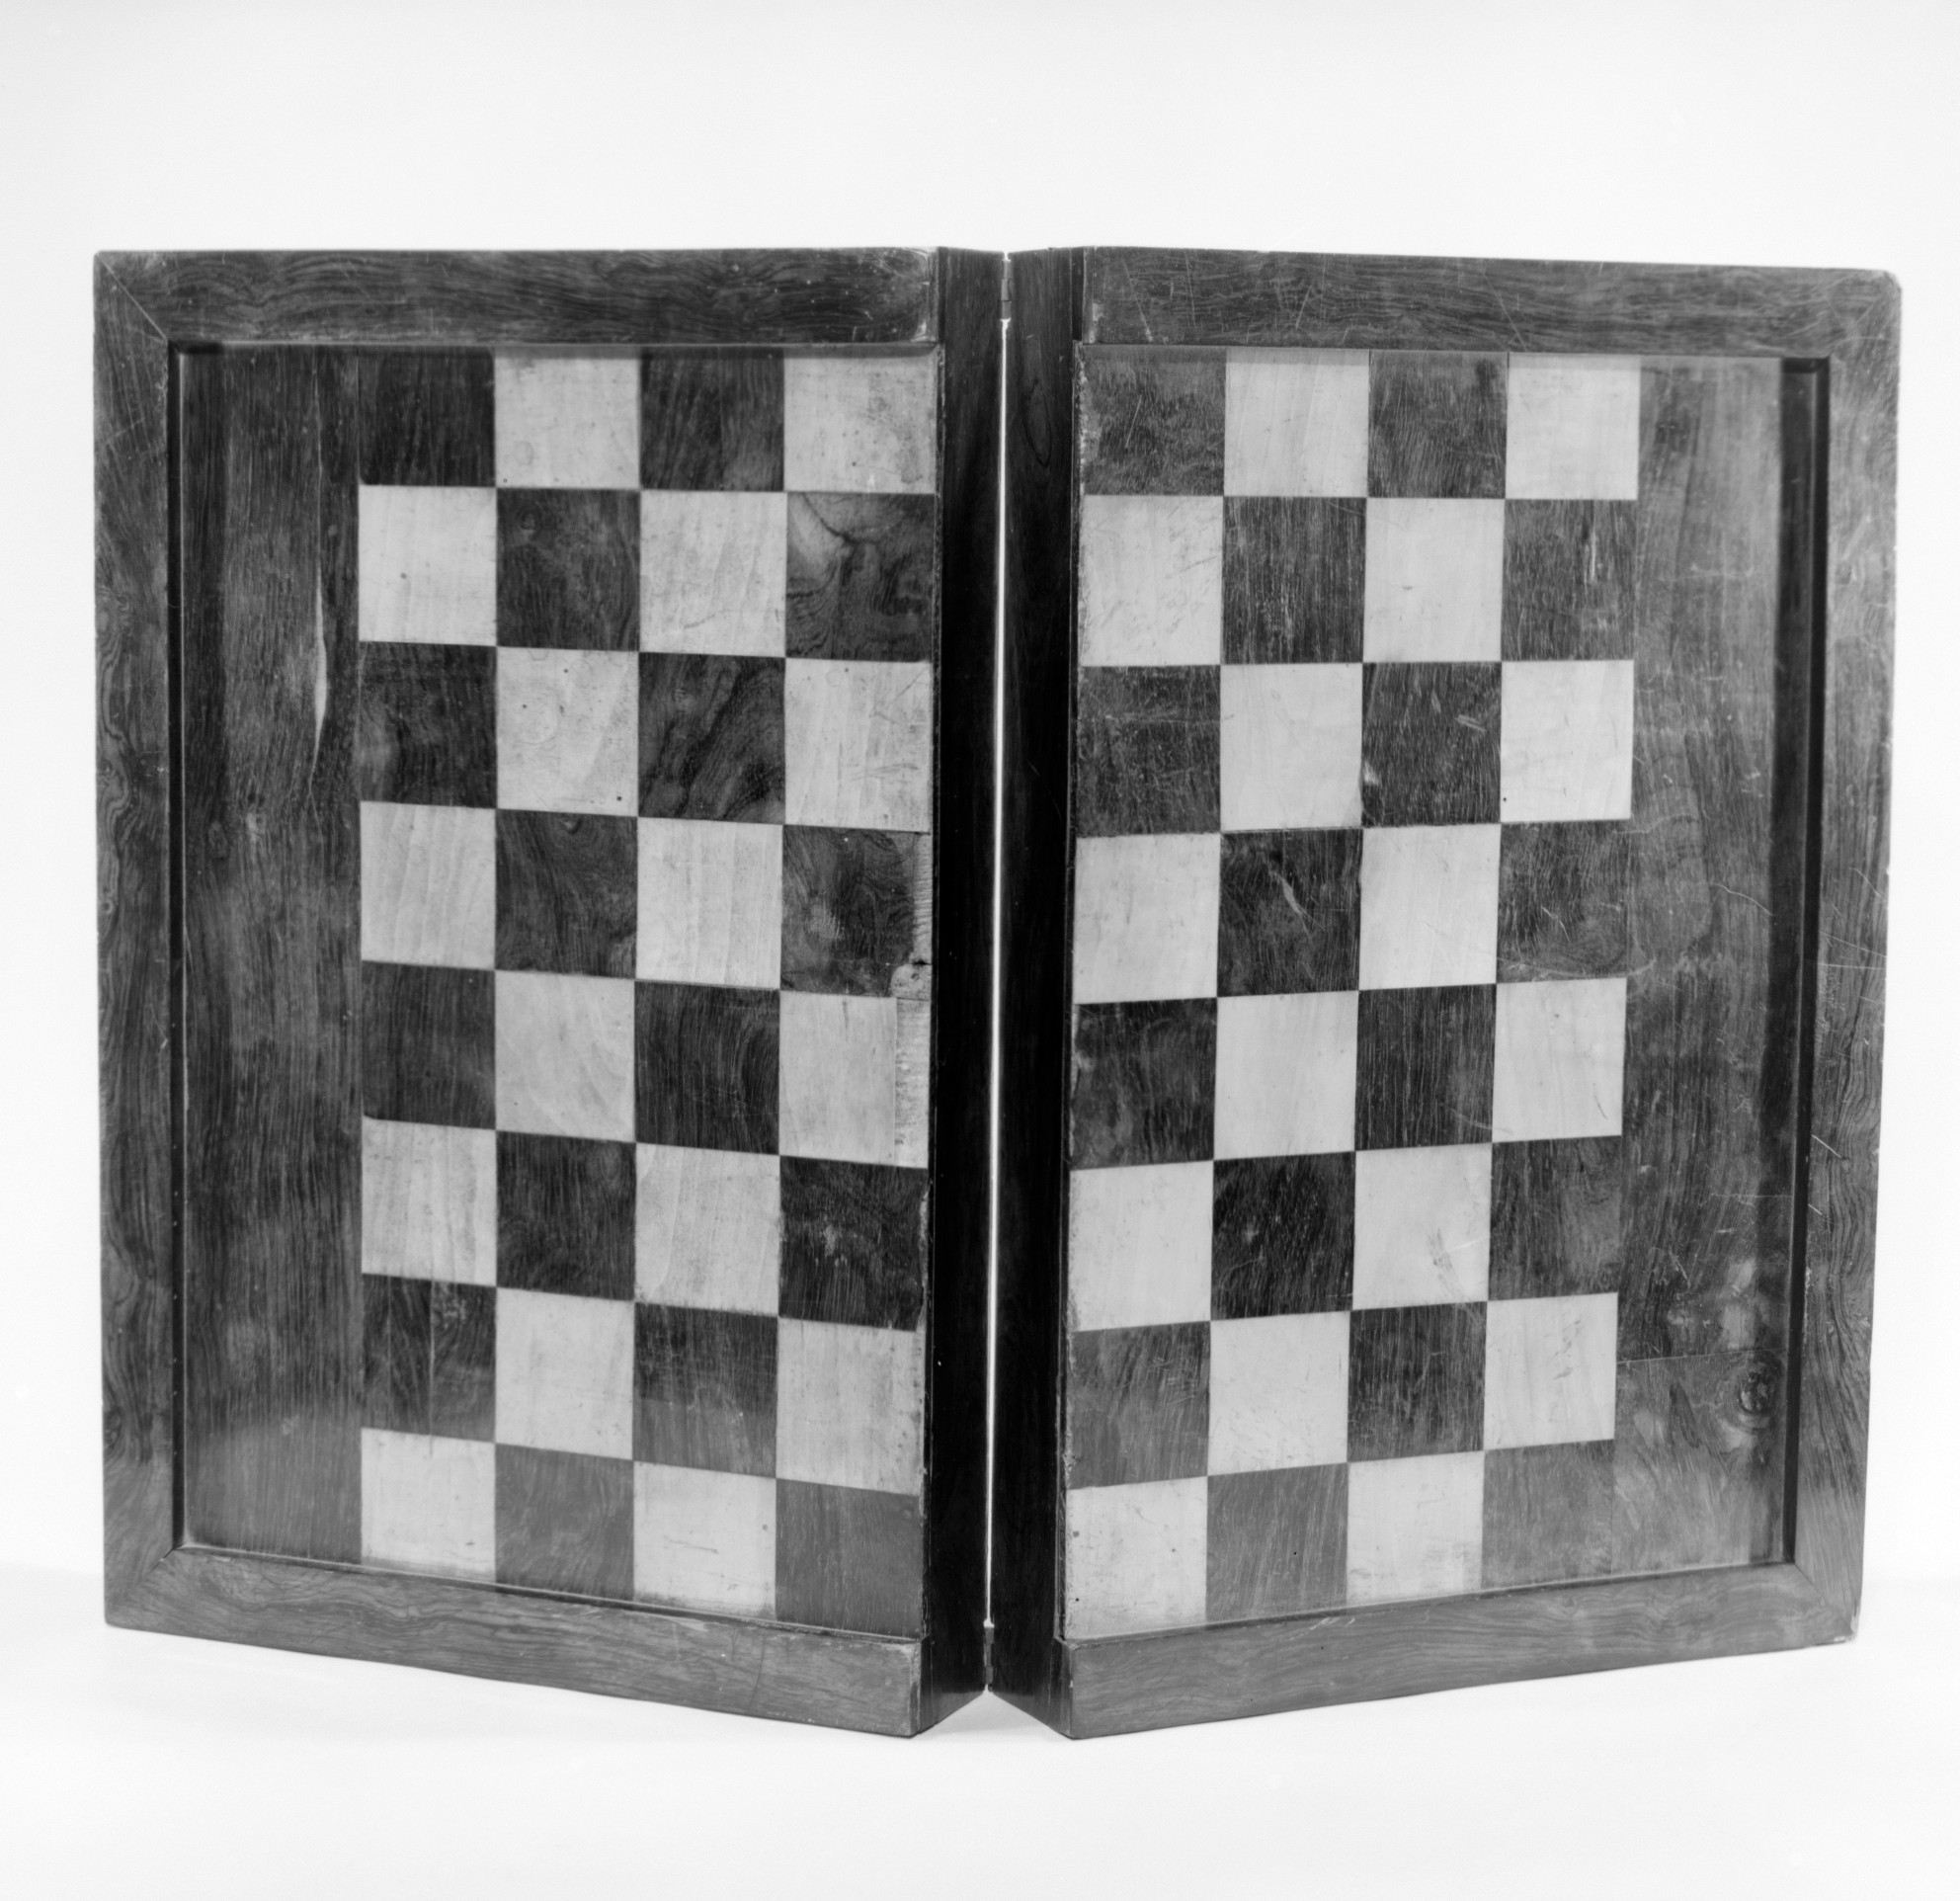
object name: chessboard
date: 1801-1900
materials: gilt brass, ivory, shell, wood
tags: chess,games